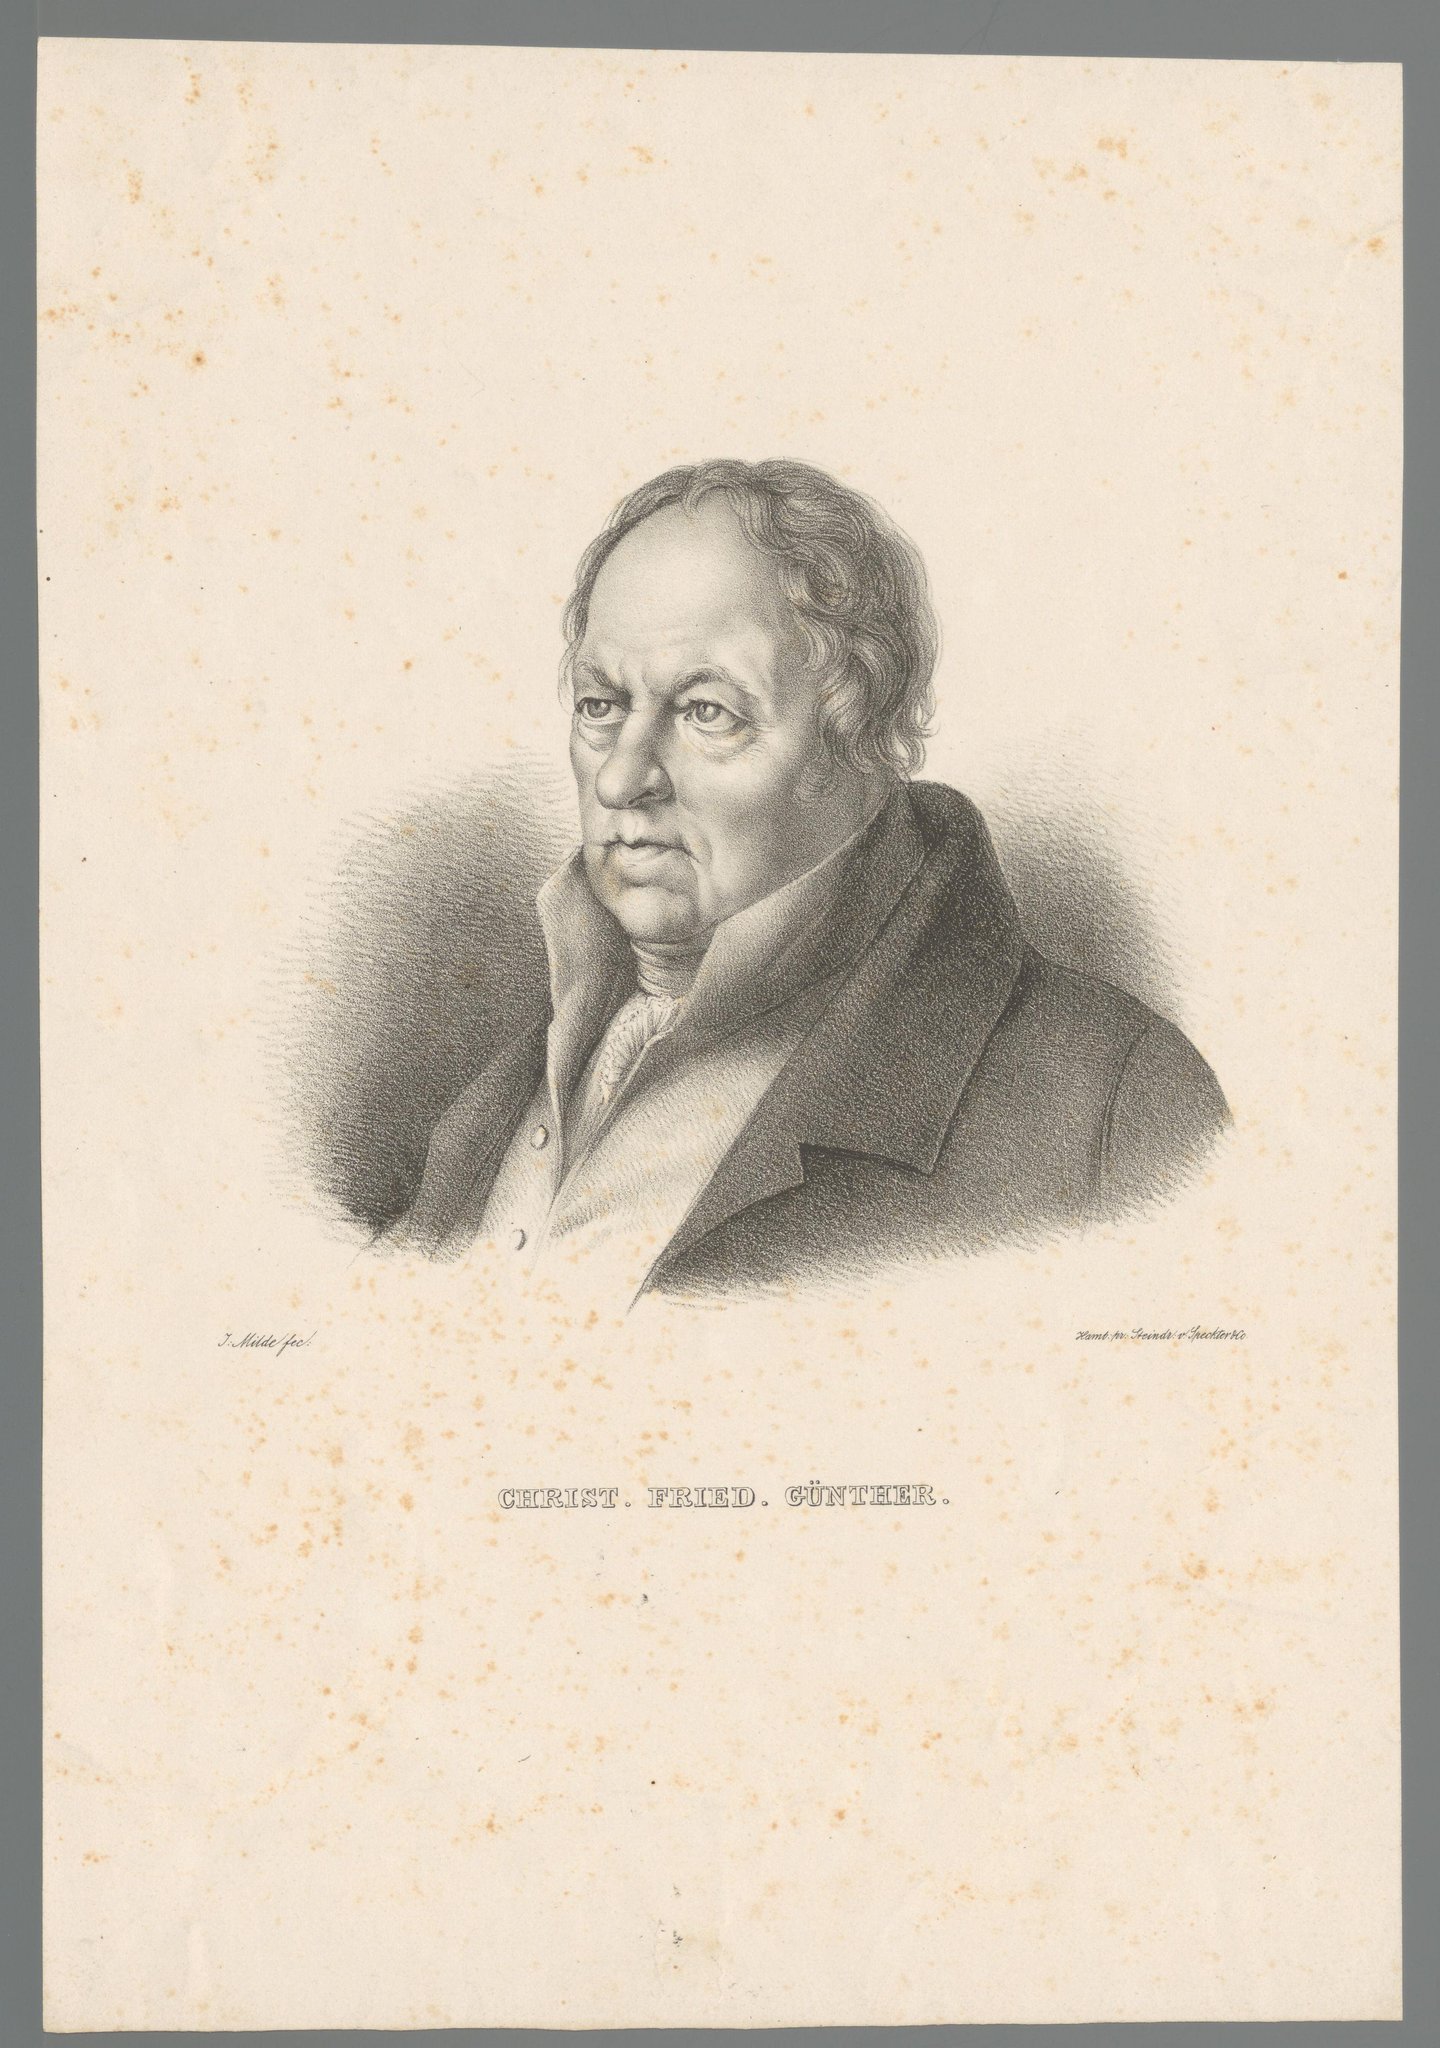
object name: print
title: Christ. Fried. Günther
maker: karl julius milde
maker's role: conservator, designer, draughtsman, painter, print maker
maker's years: 1803-1875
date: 1813-1875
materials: paper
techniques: lithograph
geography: hamburg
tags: adult man, historical persons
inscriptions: collector's mark: Lugt 2228